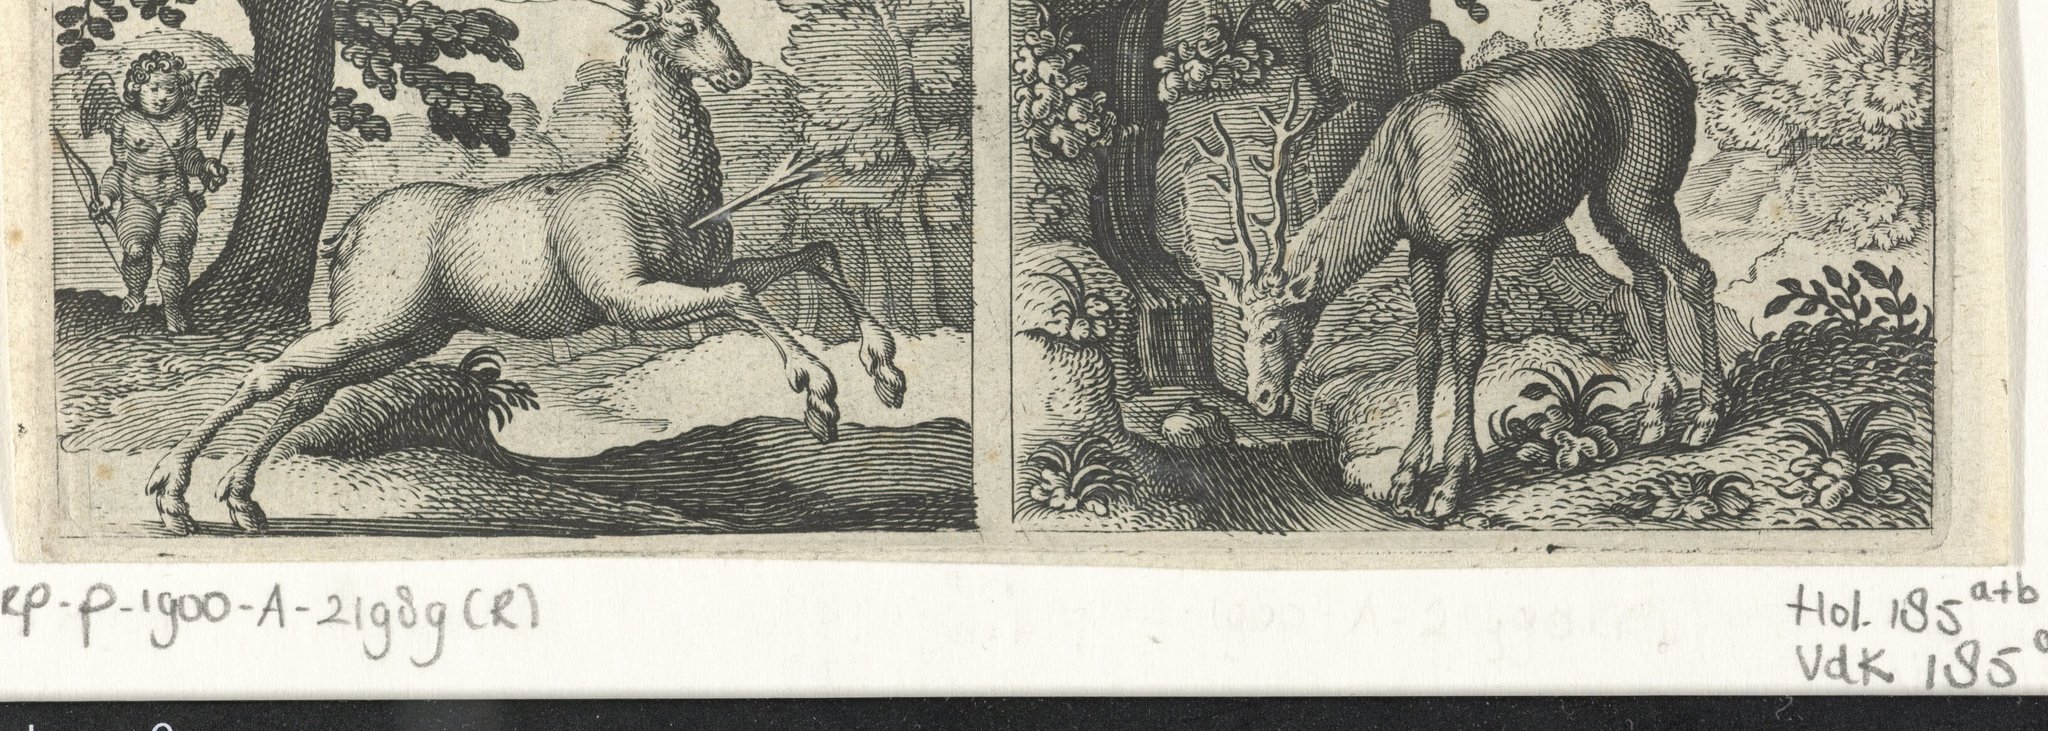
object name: print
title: Liefdesemblemen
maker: michiel le blon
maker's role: print maker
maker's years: 1587-1656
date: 1616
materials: paper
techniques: engraving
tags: hoofed animals (with name) (+ animals eating and drinking), animals (+ animal(s) being wounded), hoofed animals: deer, (story of) cupid, amor (eros), spring, source of river or stream - hh - ideal landscapes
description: Twee voorstellingen van één plaat. Links: Een hert rent door een landschap met een pijl in zijn borst. Amor staat met zijn pijl en boog onder een boom en kijkt toe. Rechts: In een landschap drinkt een hert water uit een beekje. De prenten maken deel uit van een serie prenten met liefdesemblemen.